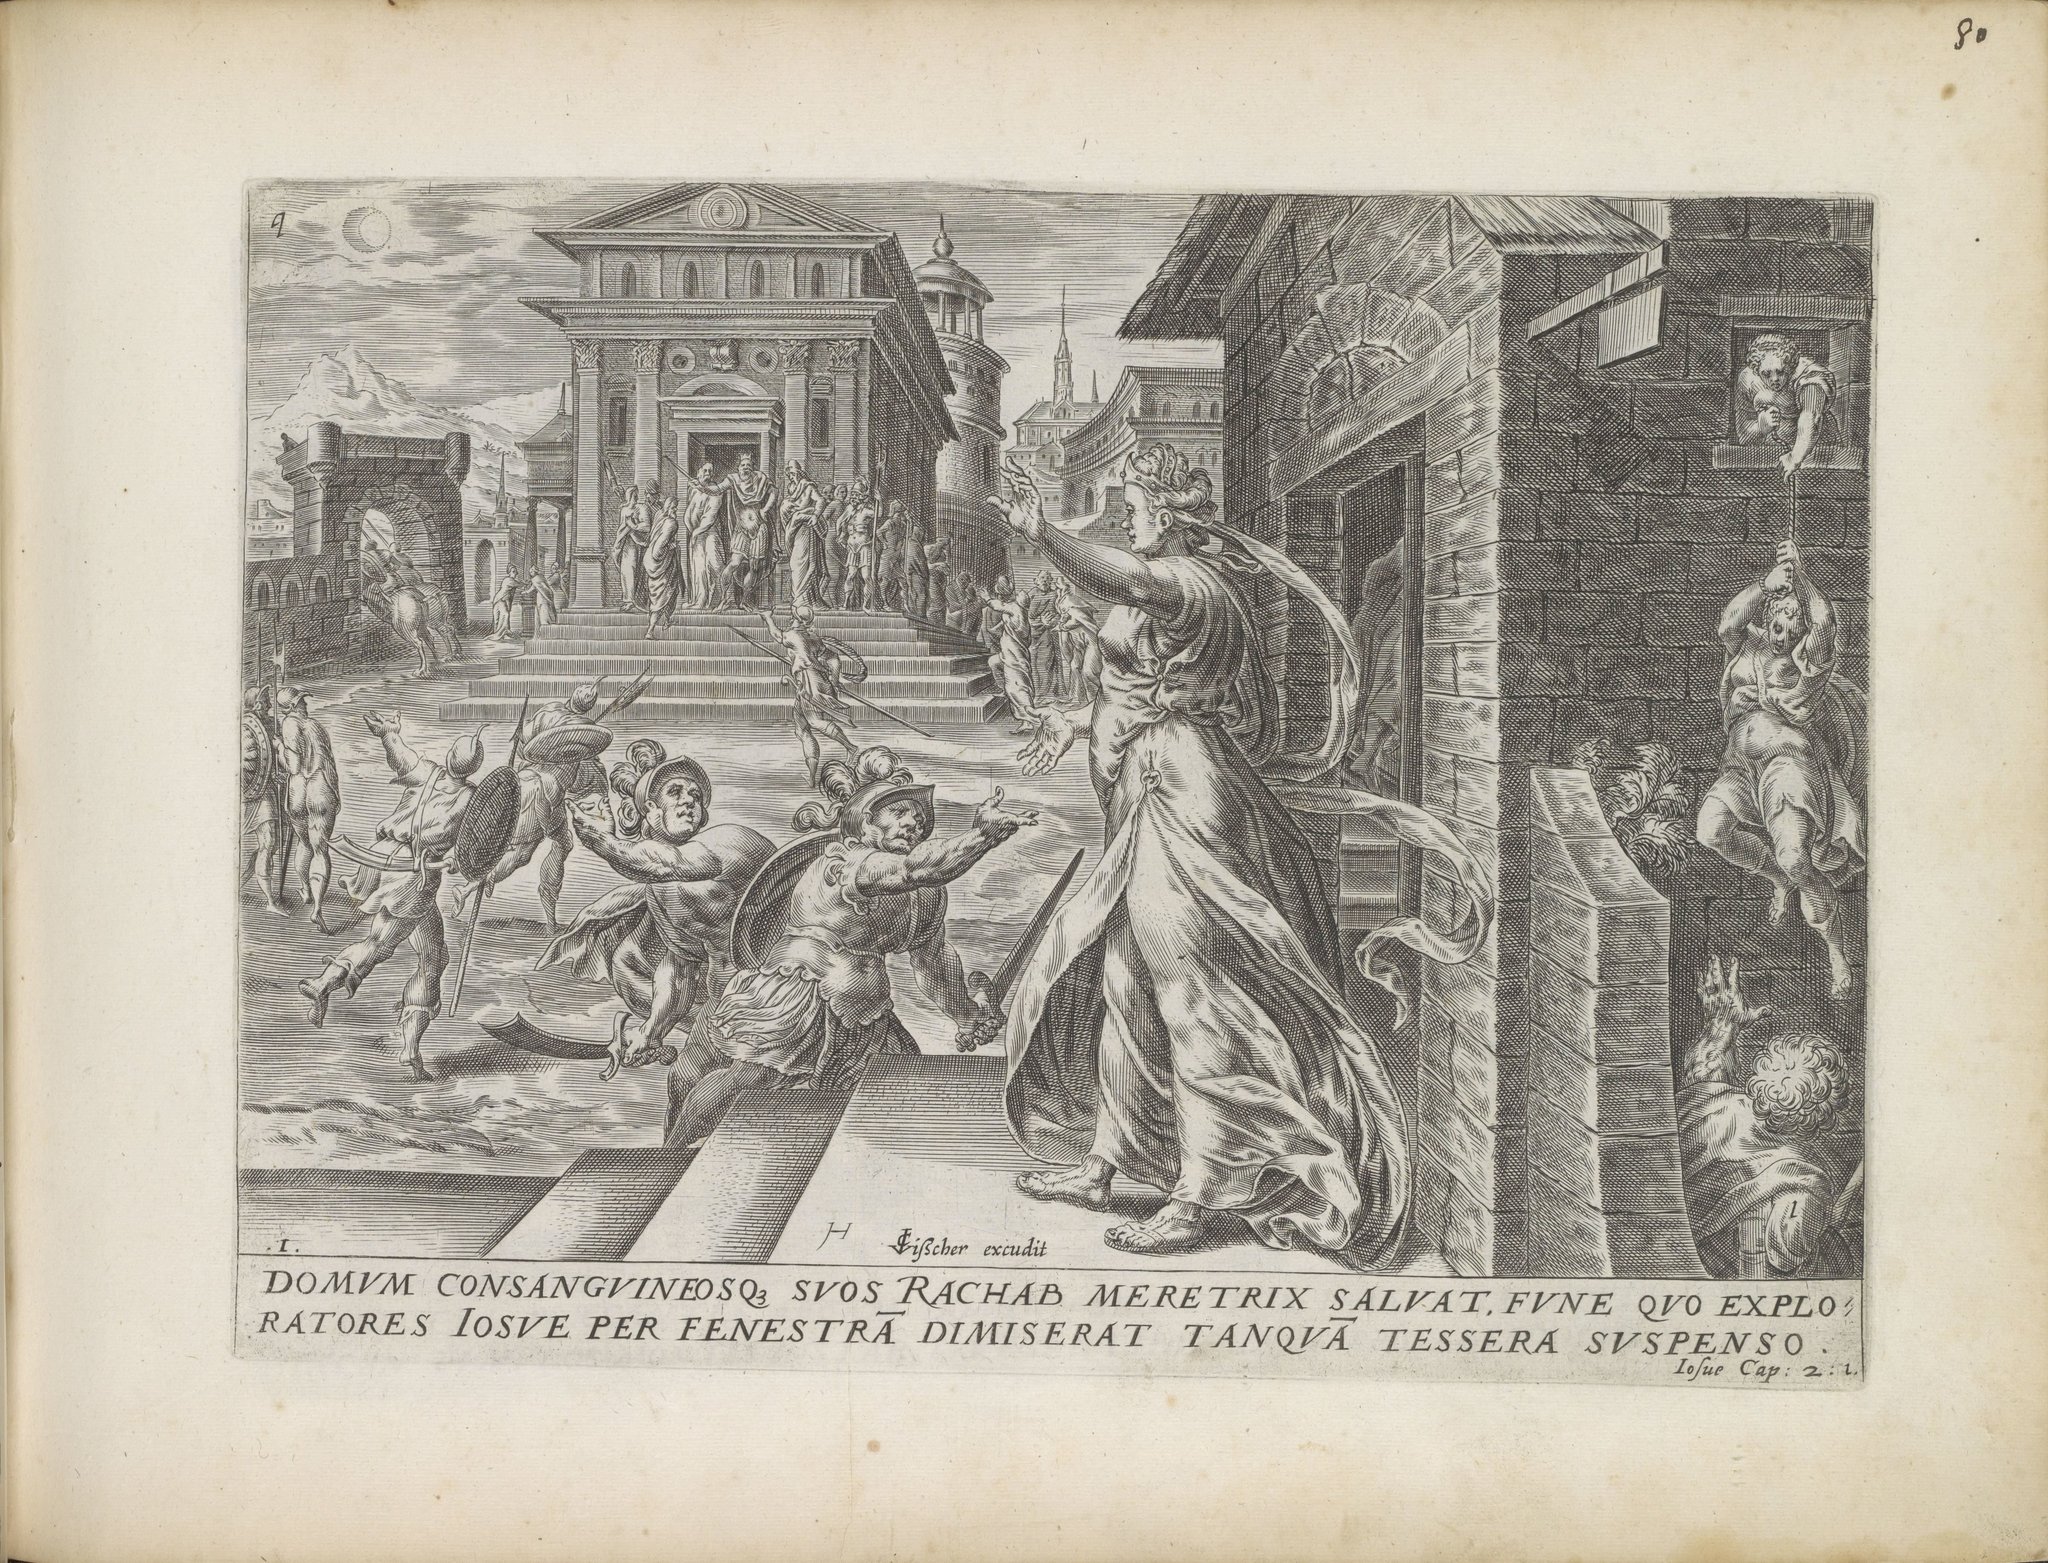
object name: album leaf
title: Rachab laat de spionnen door het raam ontsnappen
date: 1643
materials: paper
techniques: engraving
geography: amsterdam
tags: rahab, questioned by the king's men about the israelite spies, sends them on a false track, rahab, whose house was built in the city wall, lets the spies down from the window by means of a red rope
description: De prostituee Rachab staat in haar deuropening en stuurt de soldaten die gestuurd zijn om Jozua's spionnen te vinden de verkeerde kant op. Rechts is te zien hoe Rachab de twee spionnen met een touw uit haar raam laat ontsnappen. Onder de voorstelling een verwijzing in het Latijn naar de Bijbeltekst in Joz. 2:1. Deze prent maakt deel uit van een album.